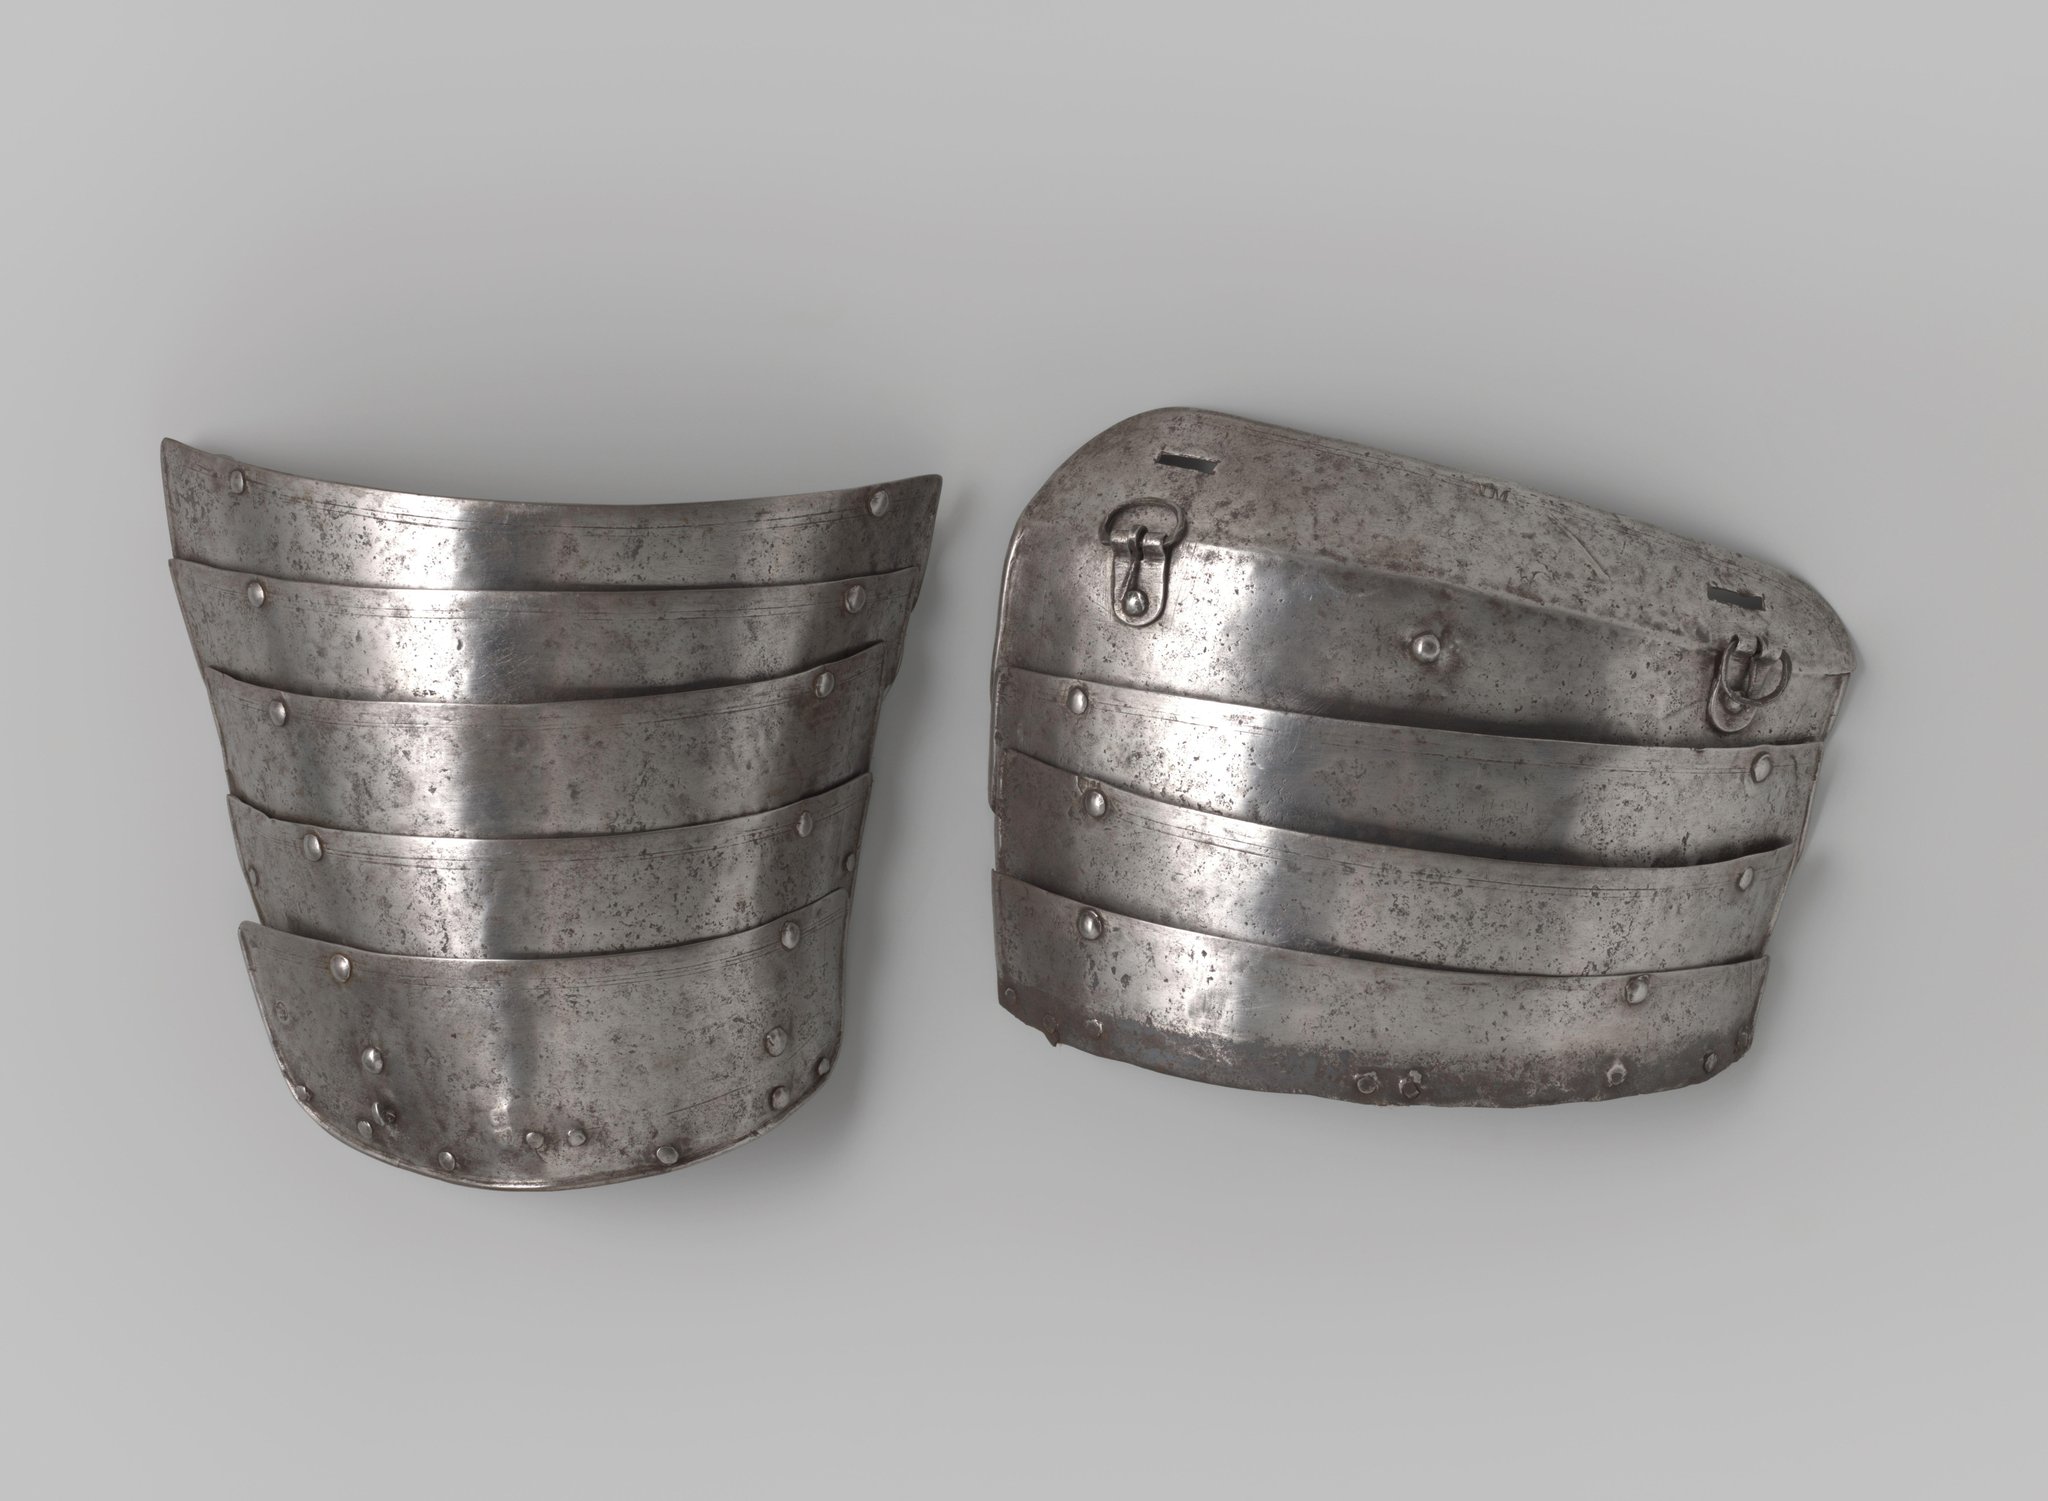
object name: beenplaat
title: Paar beenplaten behorend bij de wapenrusting, vermoedelijk gedragen door den ridder Pankraz von Freyberg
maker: Anonymous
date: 1500-1550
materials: iron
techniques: riveted, striking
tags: ridder, pankraz von freyberg, kasteel hohenaschau